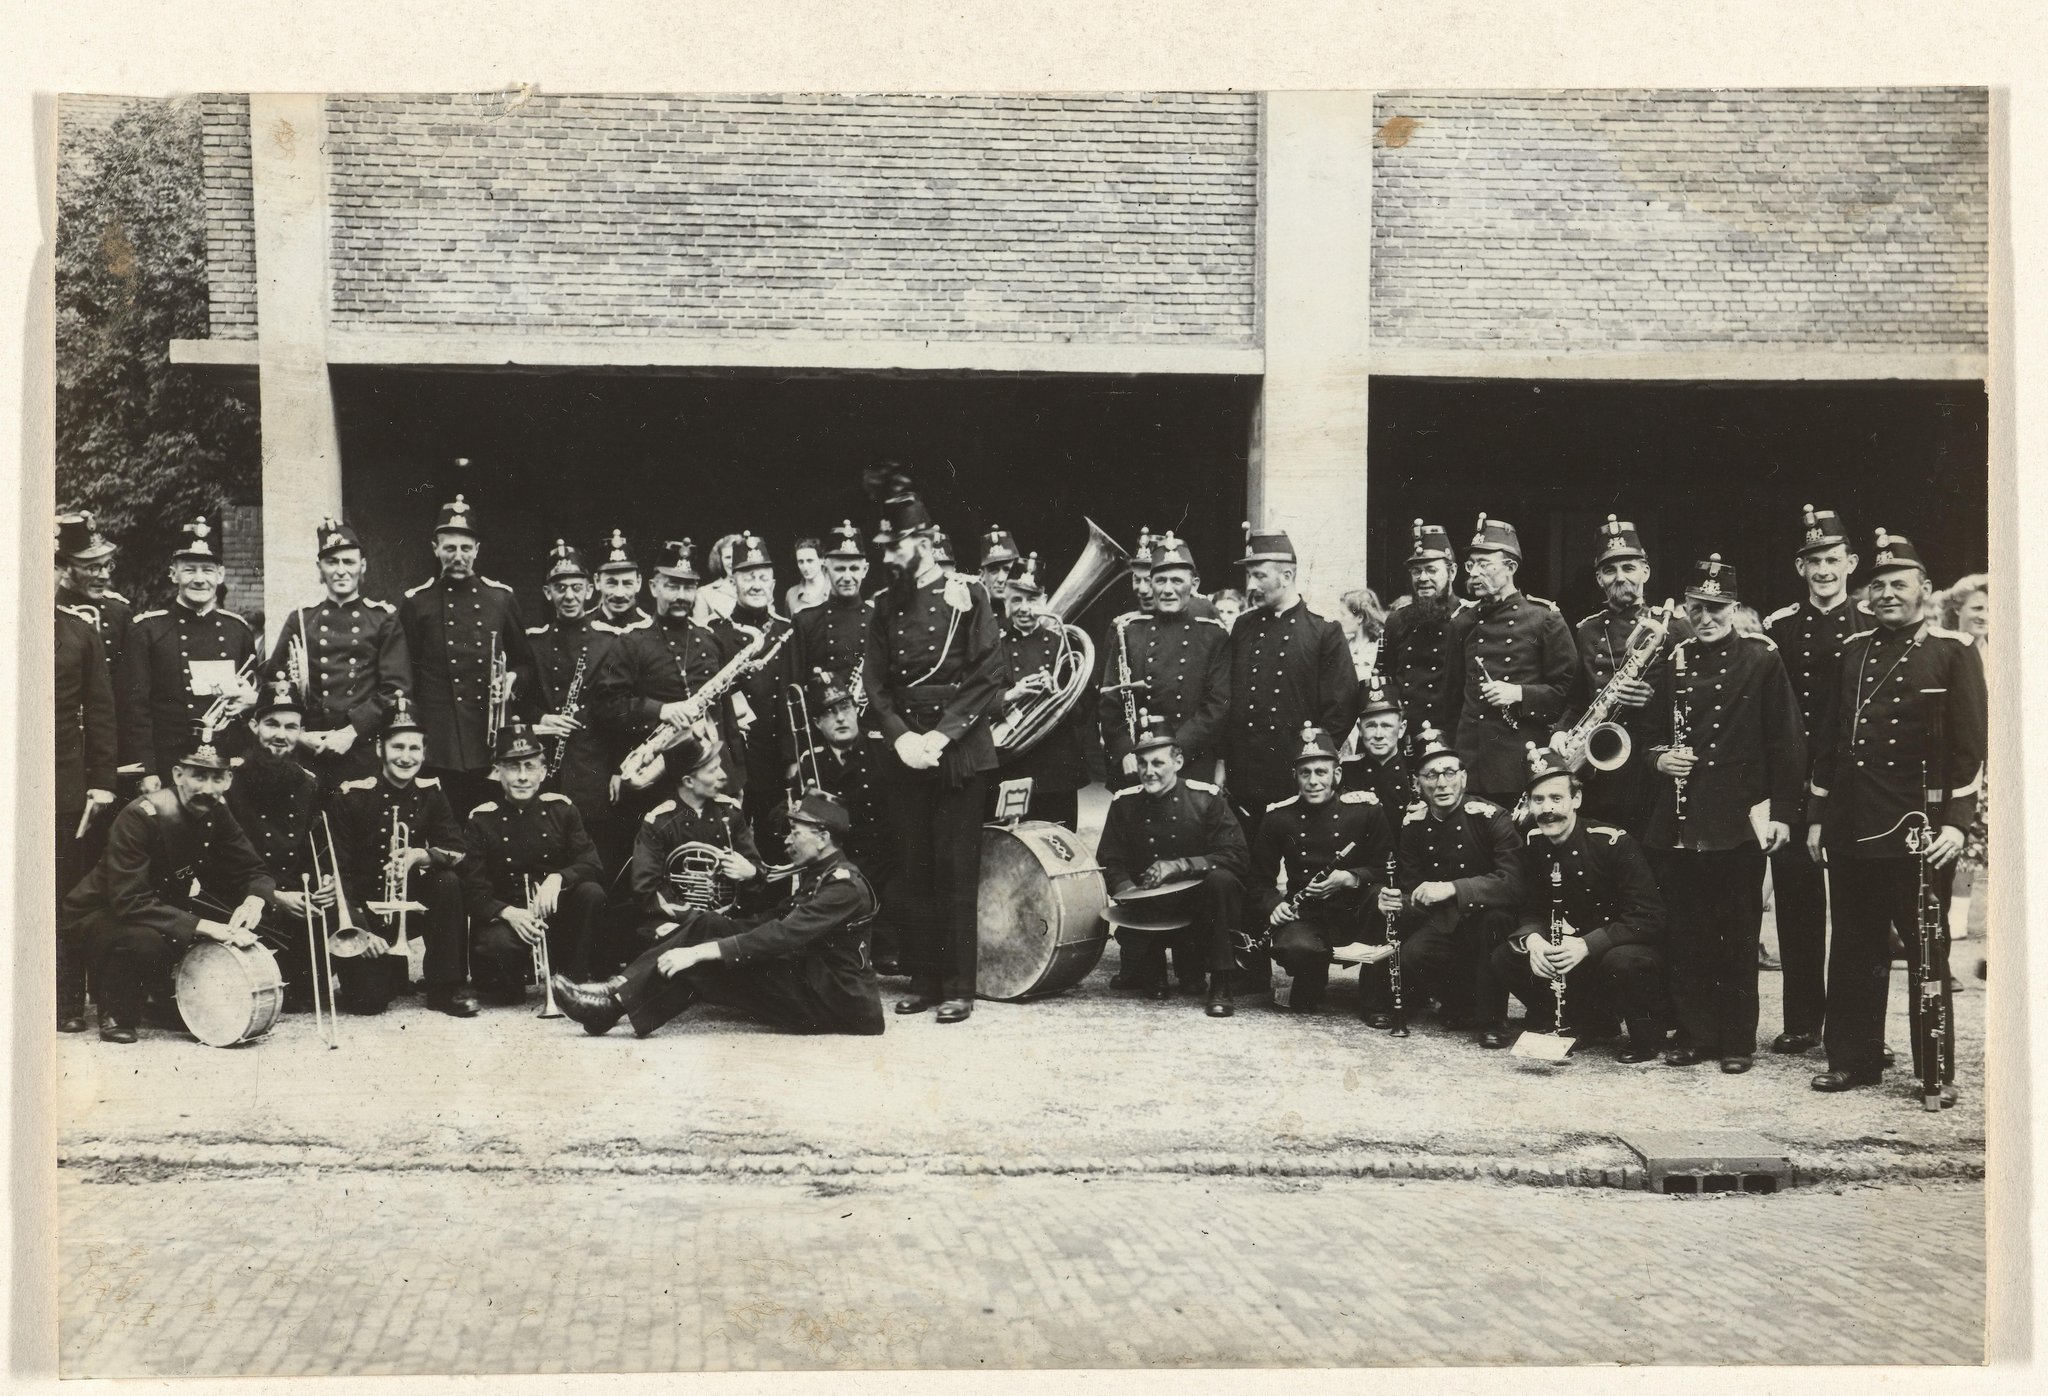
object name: photograph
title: Groepsportret van het marinemuziekgezelschap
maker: Anonymous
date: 1946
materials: photographic support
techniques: gelatin silver print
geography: netherlands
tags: musical instruments; group of musical instruments, anonymous historical persons portrayed in a group, in a group-portrait, netherlands